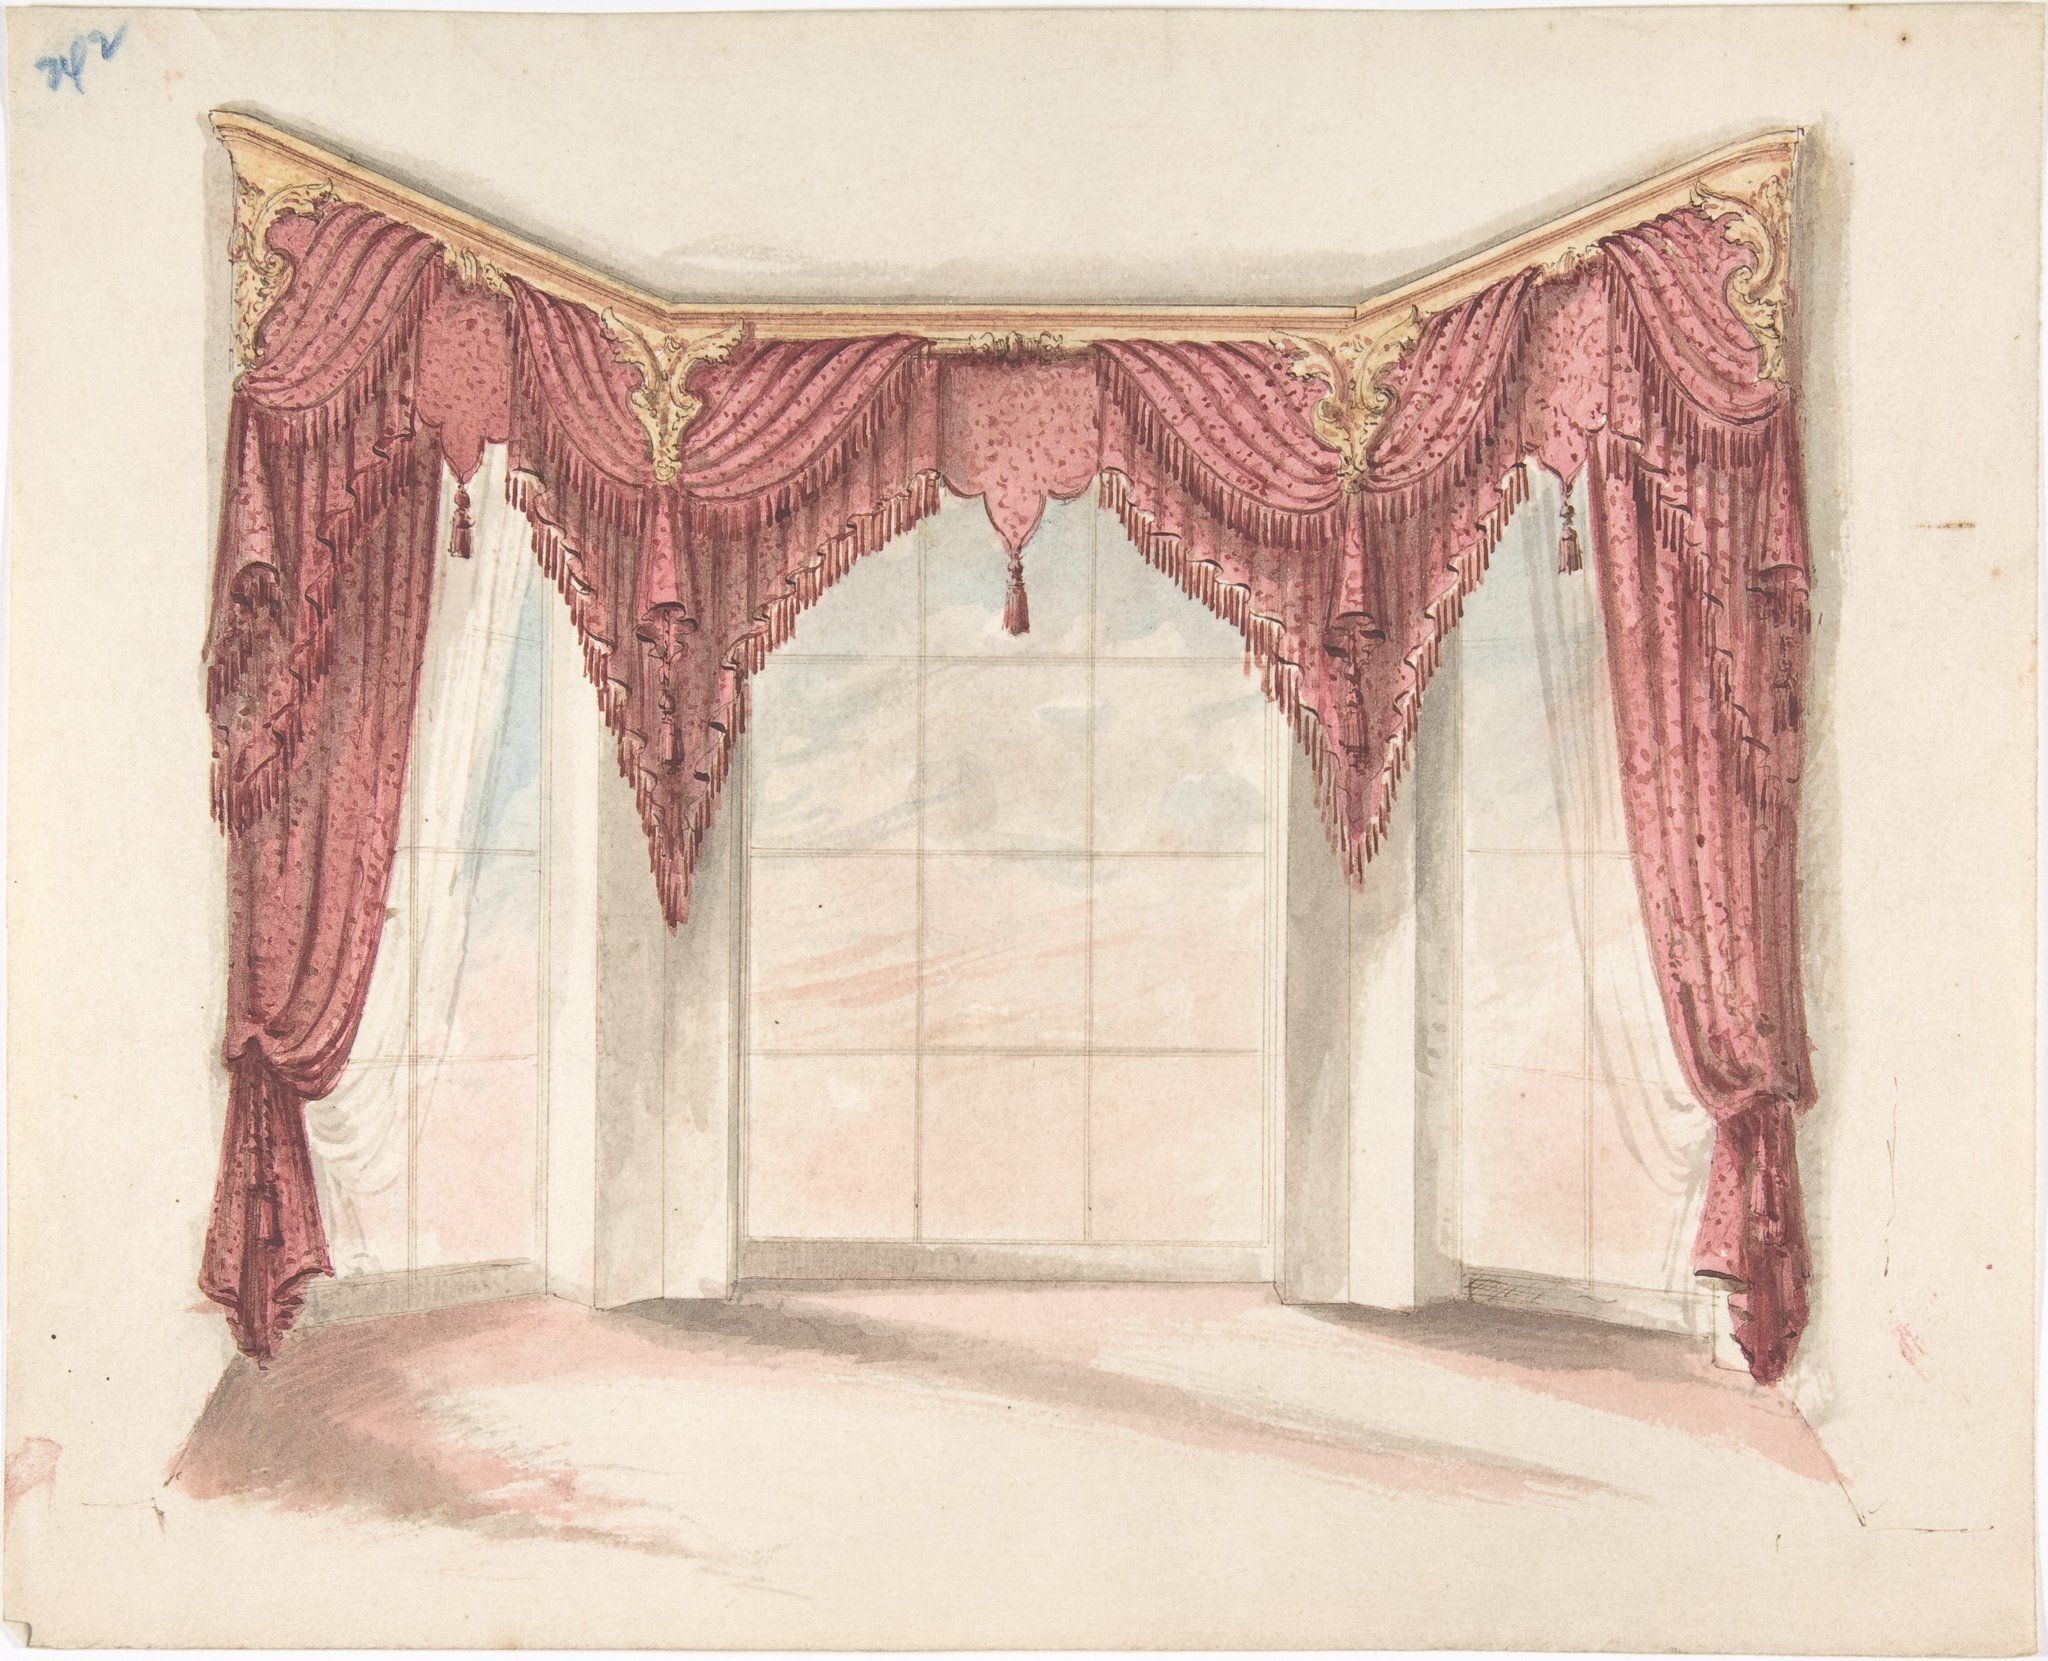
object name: drawing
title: Design for Red Curtains with Red Fringes and a Gold Pediment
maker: anonymous, british, 19th century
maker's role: artist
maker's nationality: british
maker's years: 1800-1900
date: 1801-1833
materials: ink, watercolor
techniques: brush, pen, wash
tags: windows,curtains